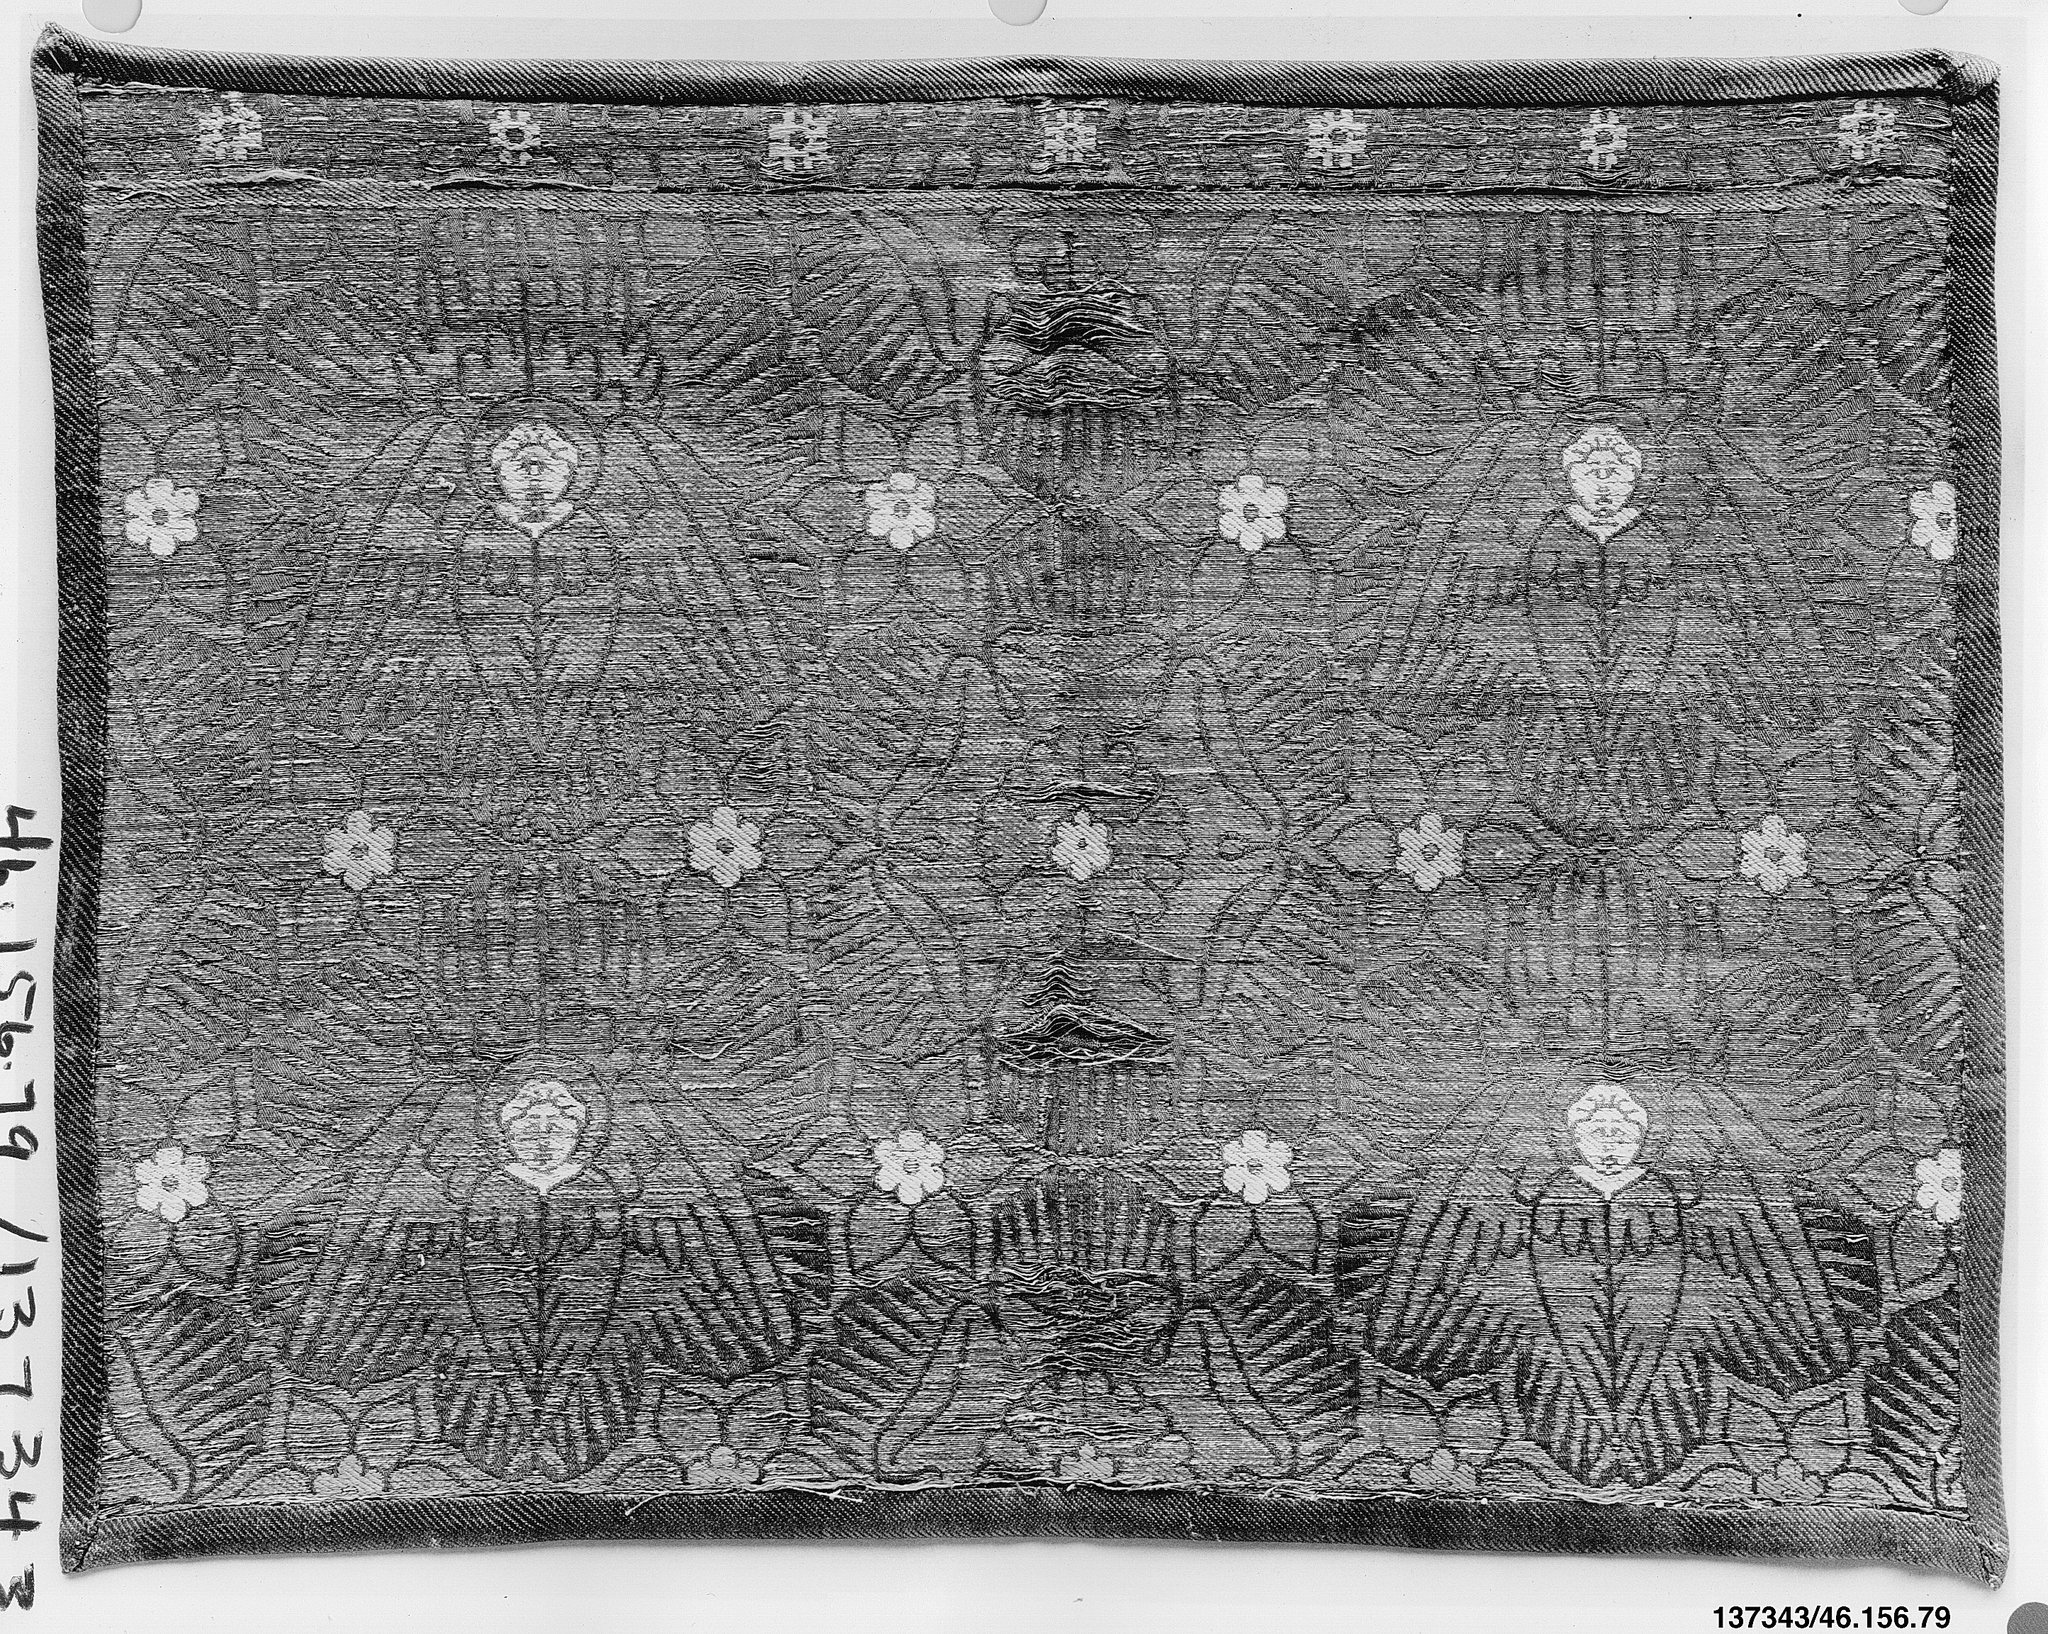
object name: piece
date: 1401-1450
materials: metal thread, silk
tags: flowers